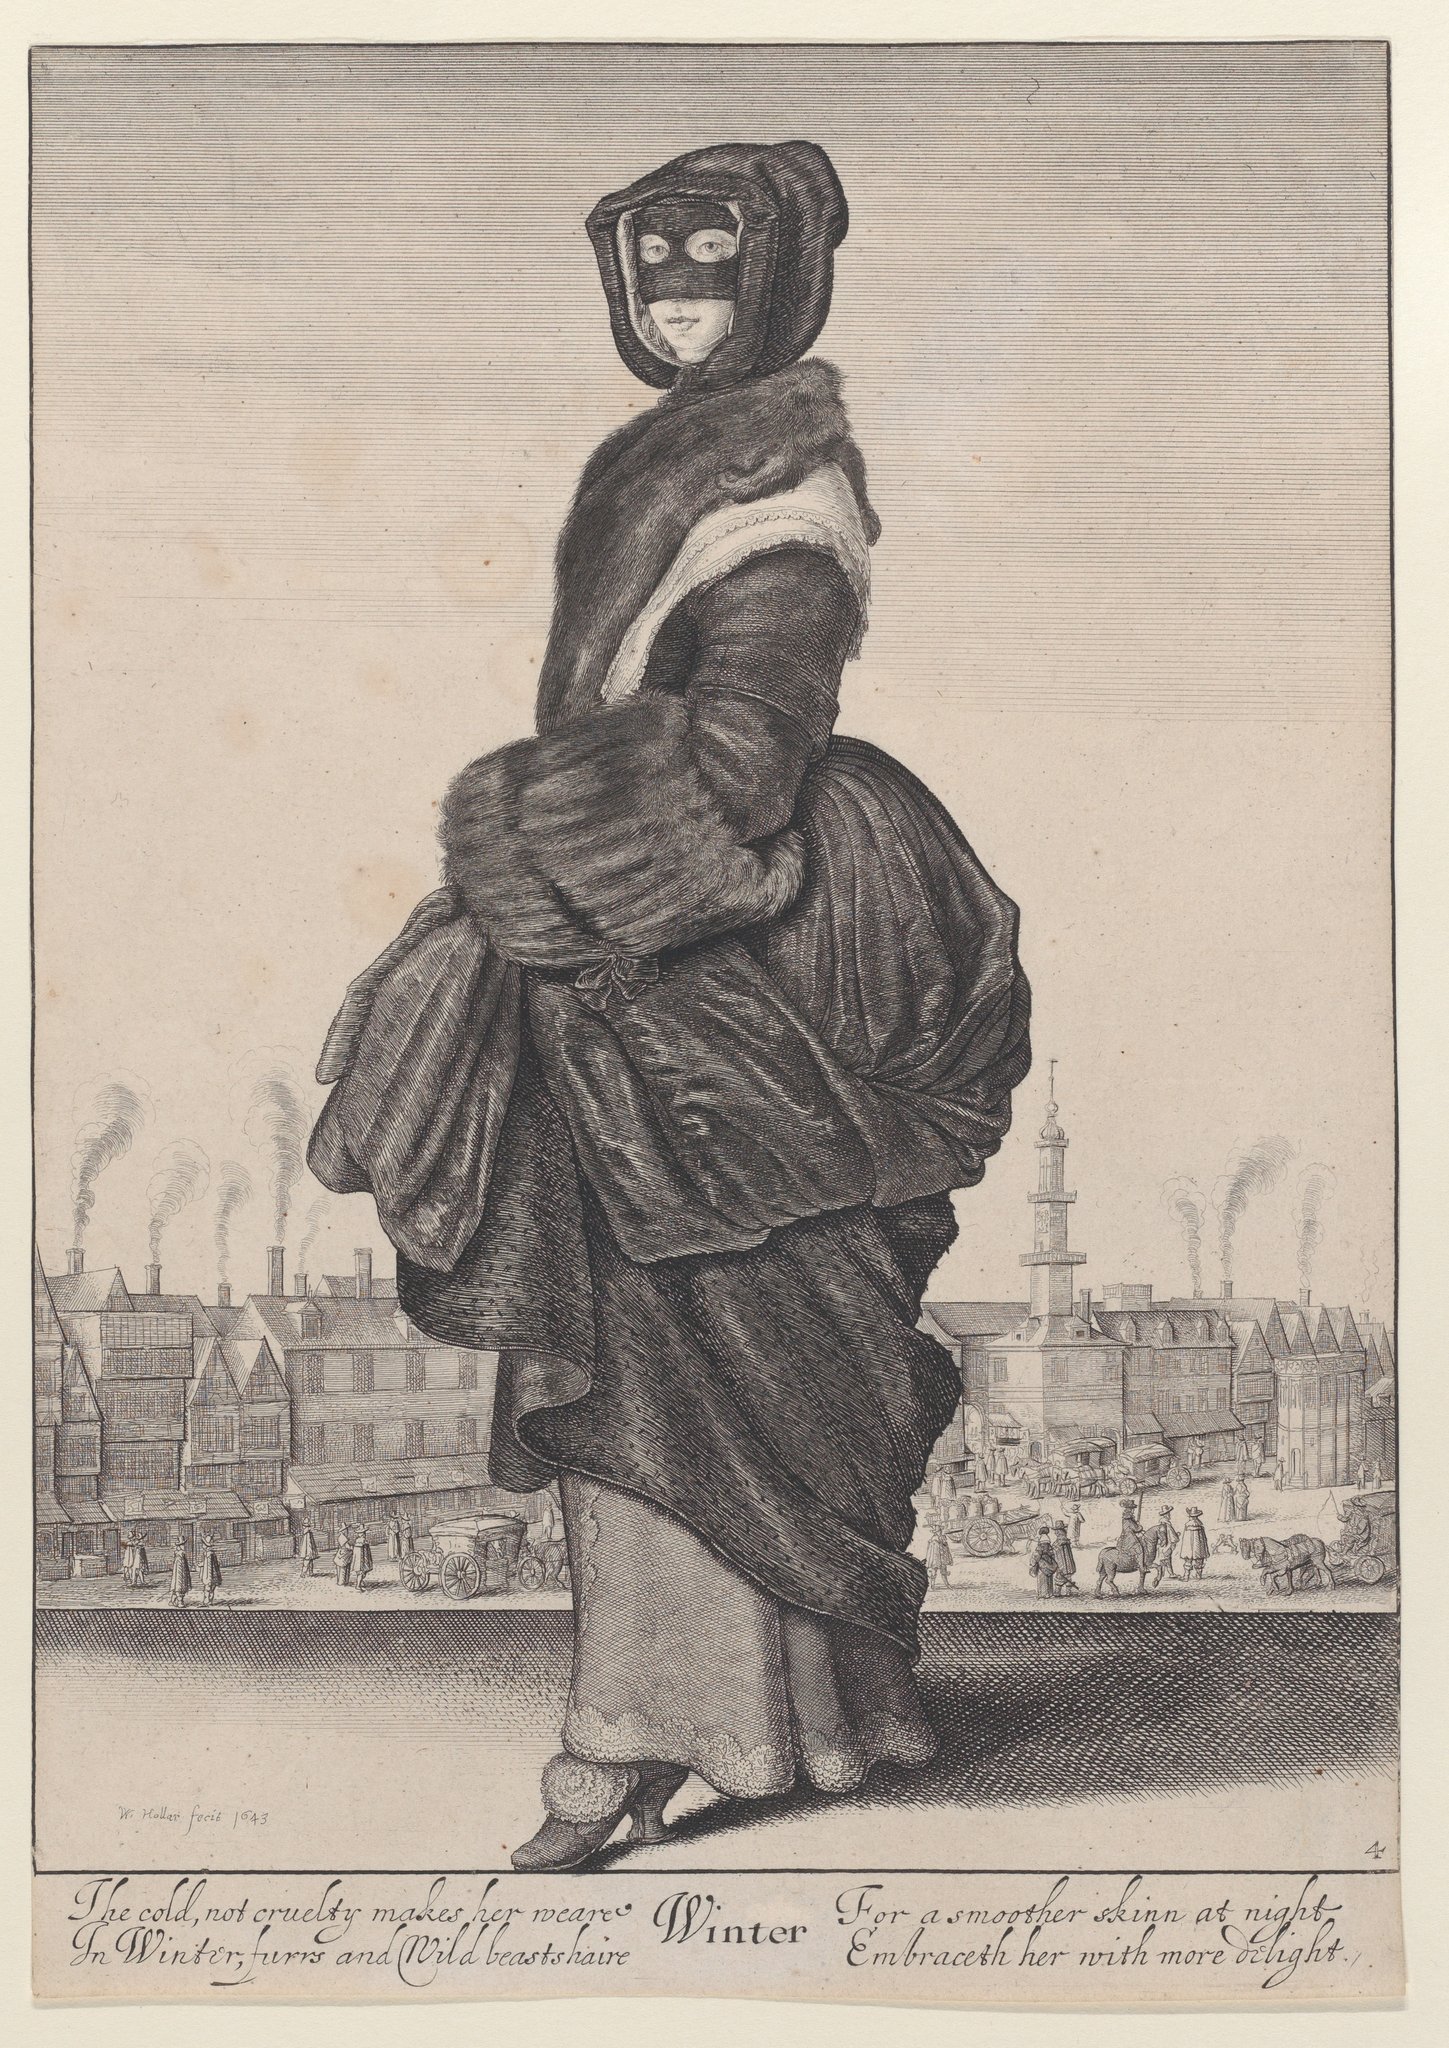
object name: print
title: Winter, from "Full-Length Seasons"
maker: wenceslaus hollar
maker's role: artist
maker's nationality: bohemian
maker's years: 1607-1677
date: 1643-1644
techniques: etching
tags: women